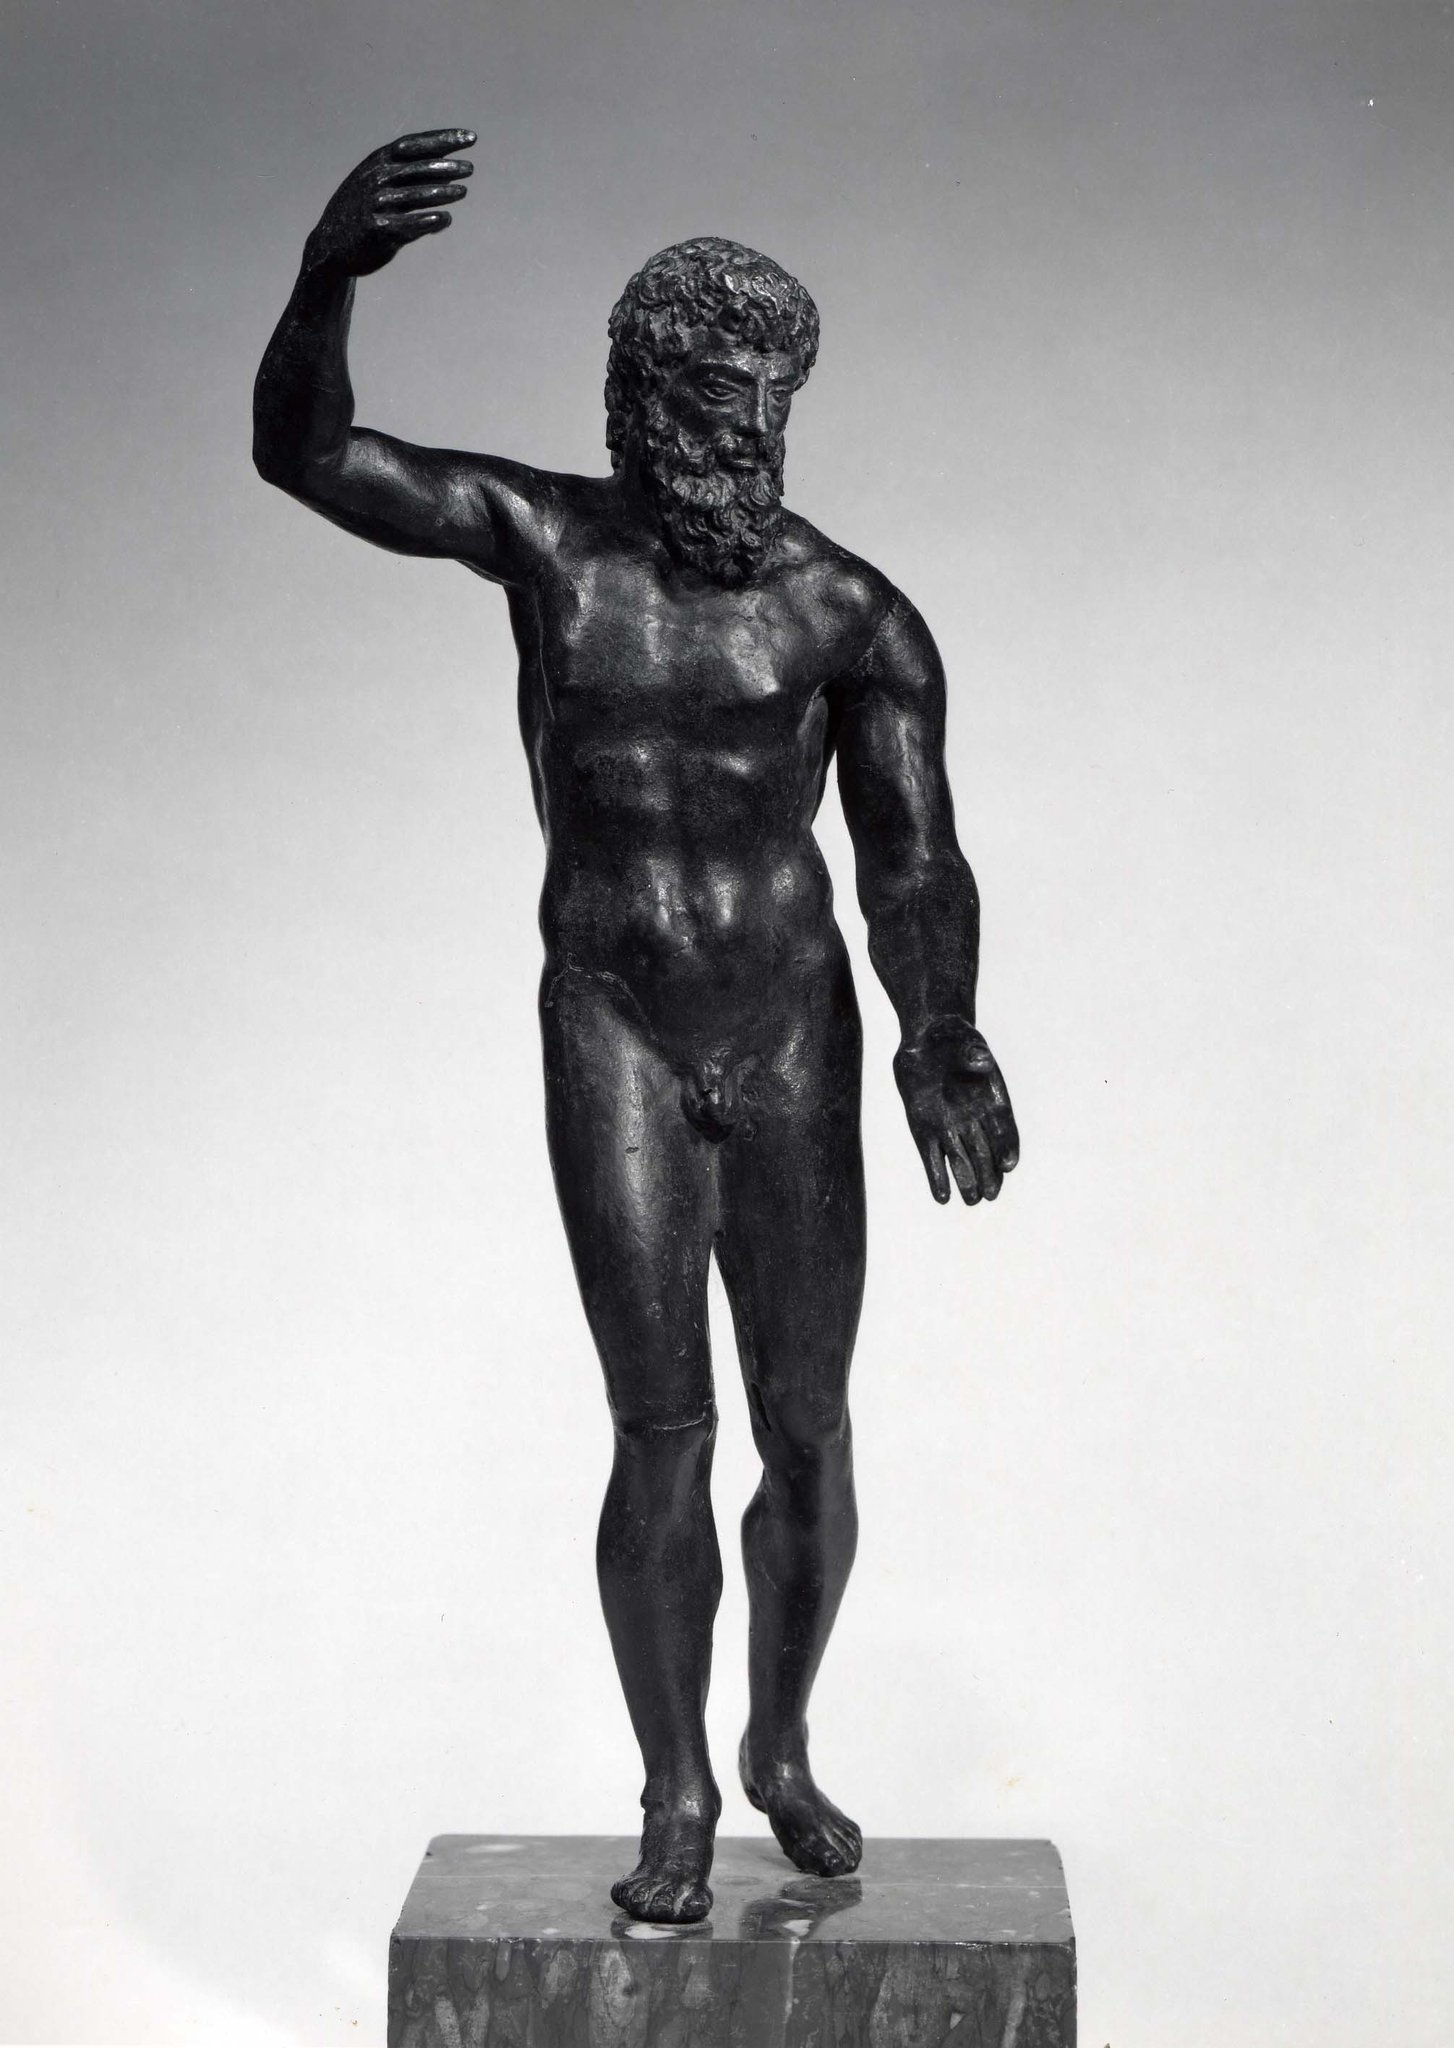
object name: sculpture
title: Neptune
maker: pietro da barga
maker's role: artist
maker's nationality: italian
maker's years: 1574-1588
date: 1580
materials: copper alloy, patina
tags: male nudes,neptune